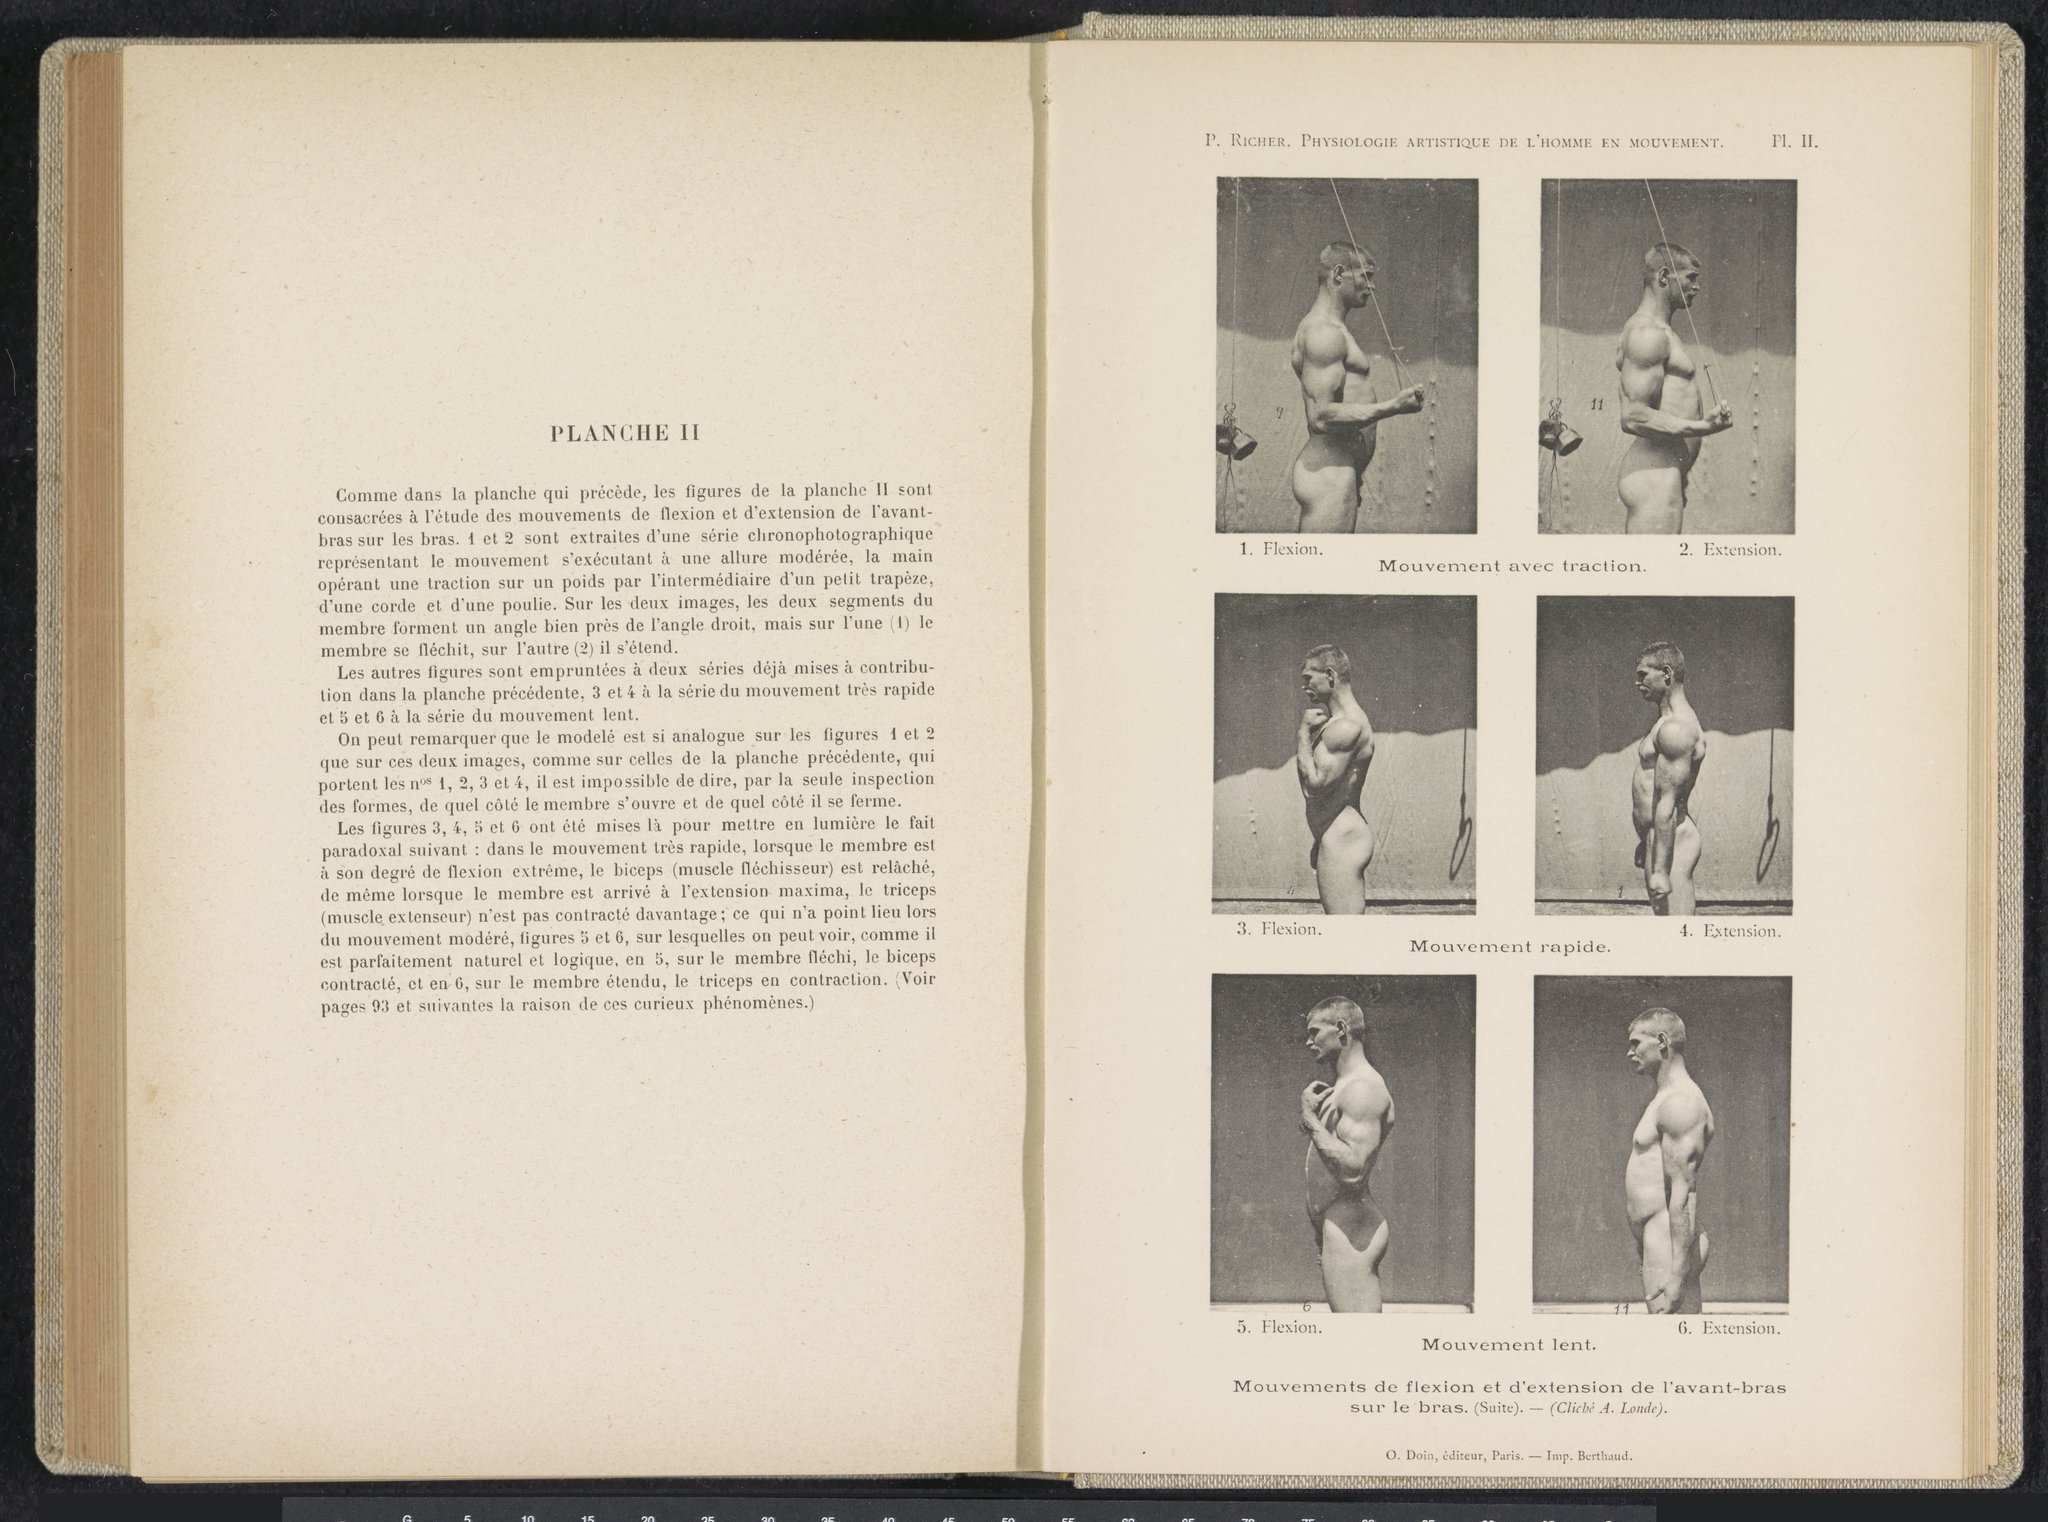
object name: page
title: Mouvements de flexion et d'extension de l'avant-bras sur le bras (Suite)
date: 1885-1895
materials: paper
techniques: photograph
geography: france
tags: movements of the human body, anatomy (non-medical), man (showing himself) undressed, quasi-nude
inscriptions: number: ‘1. (...) 6.’, inscription: ‘Flexion. (...) Extension.’, number: ‘7, 11, 4, 1, 6, 11’, number: ‘Pl. II.’